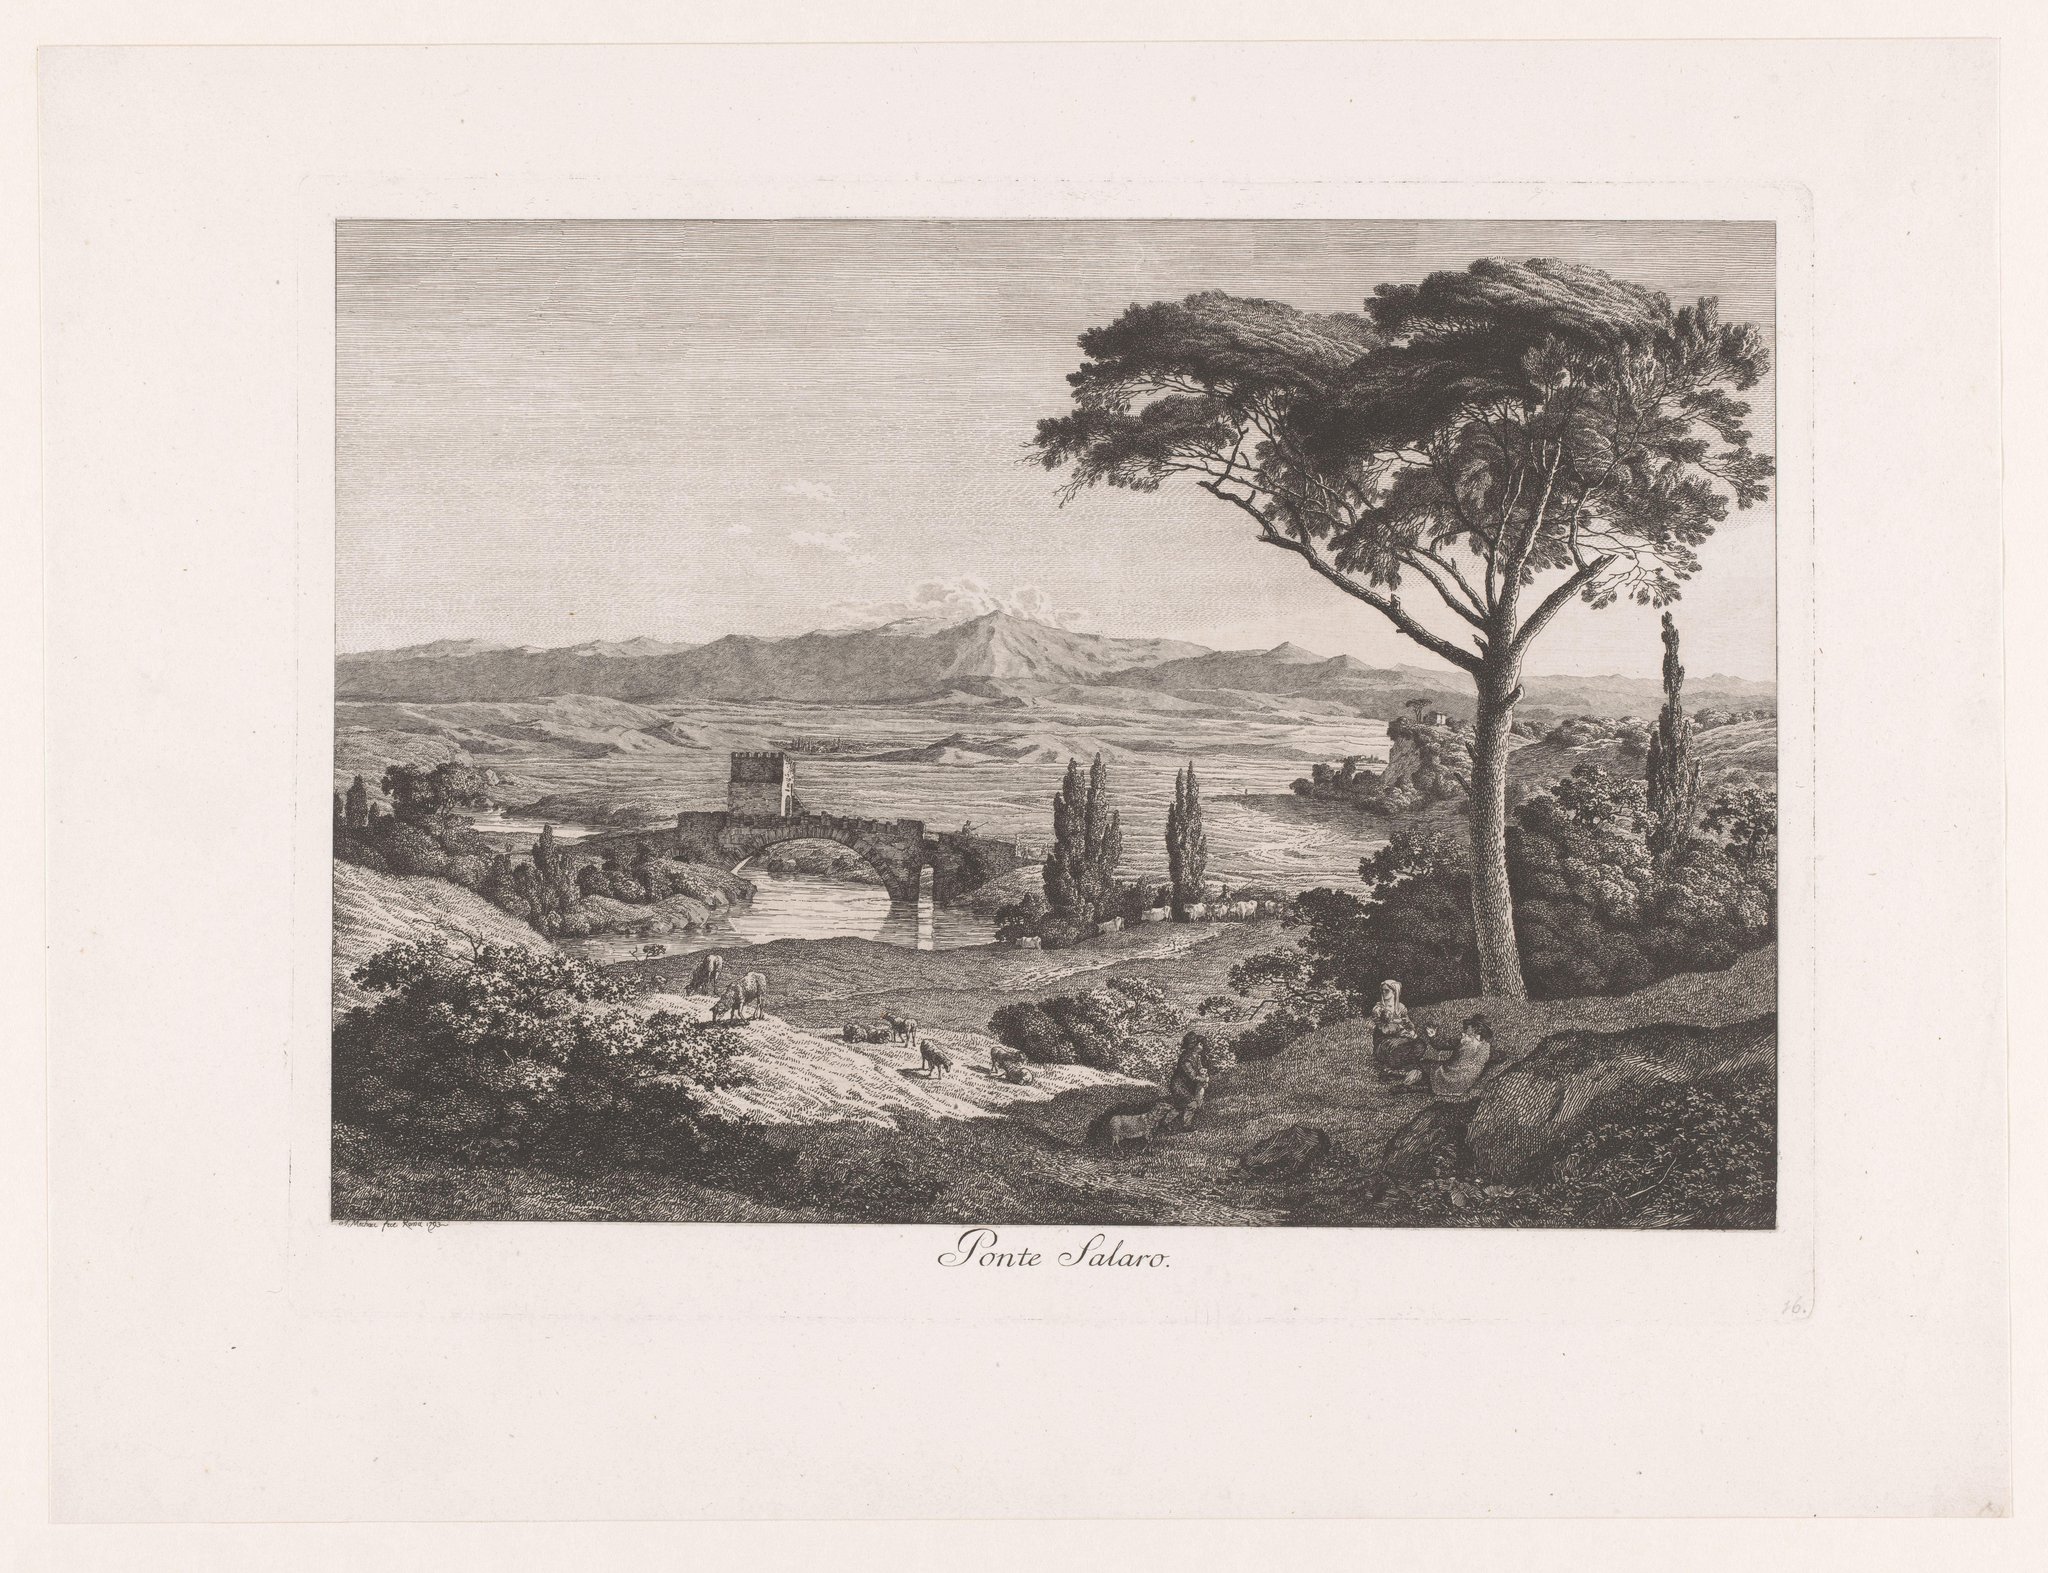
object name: print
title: Italiaanse landschappen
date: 1793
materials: paper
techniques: etching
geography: rome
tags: landscape with bridge, viaduct or aqueduct (+ city(-scape) with figures, staffage)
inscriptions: collector's mark: Lugt 2228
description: Behorend tot een set van 72 'Mahlerisch-radirte Prospecte von Italien', waarvoor de kunstenaar 24 prenten maakte. Albert Christoph Dies (1755-1822) en Johann Christian Reinhart (1761-1847) maakten eveneens 24 platen, in opdracht van Jean Fréderic Frauenholz.